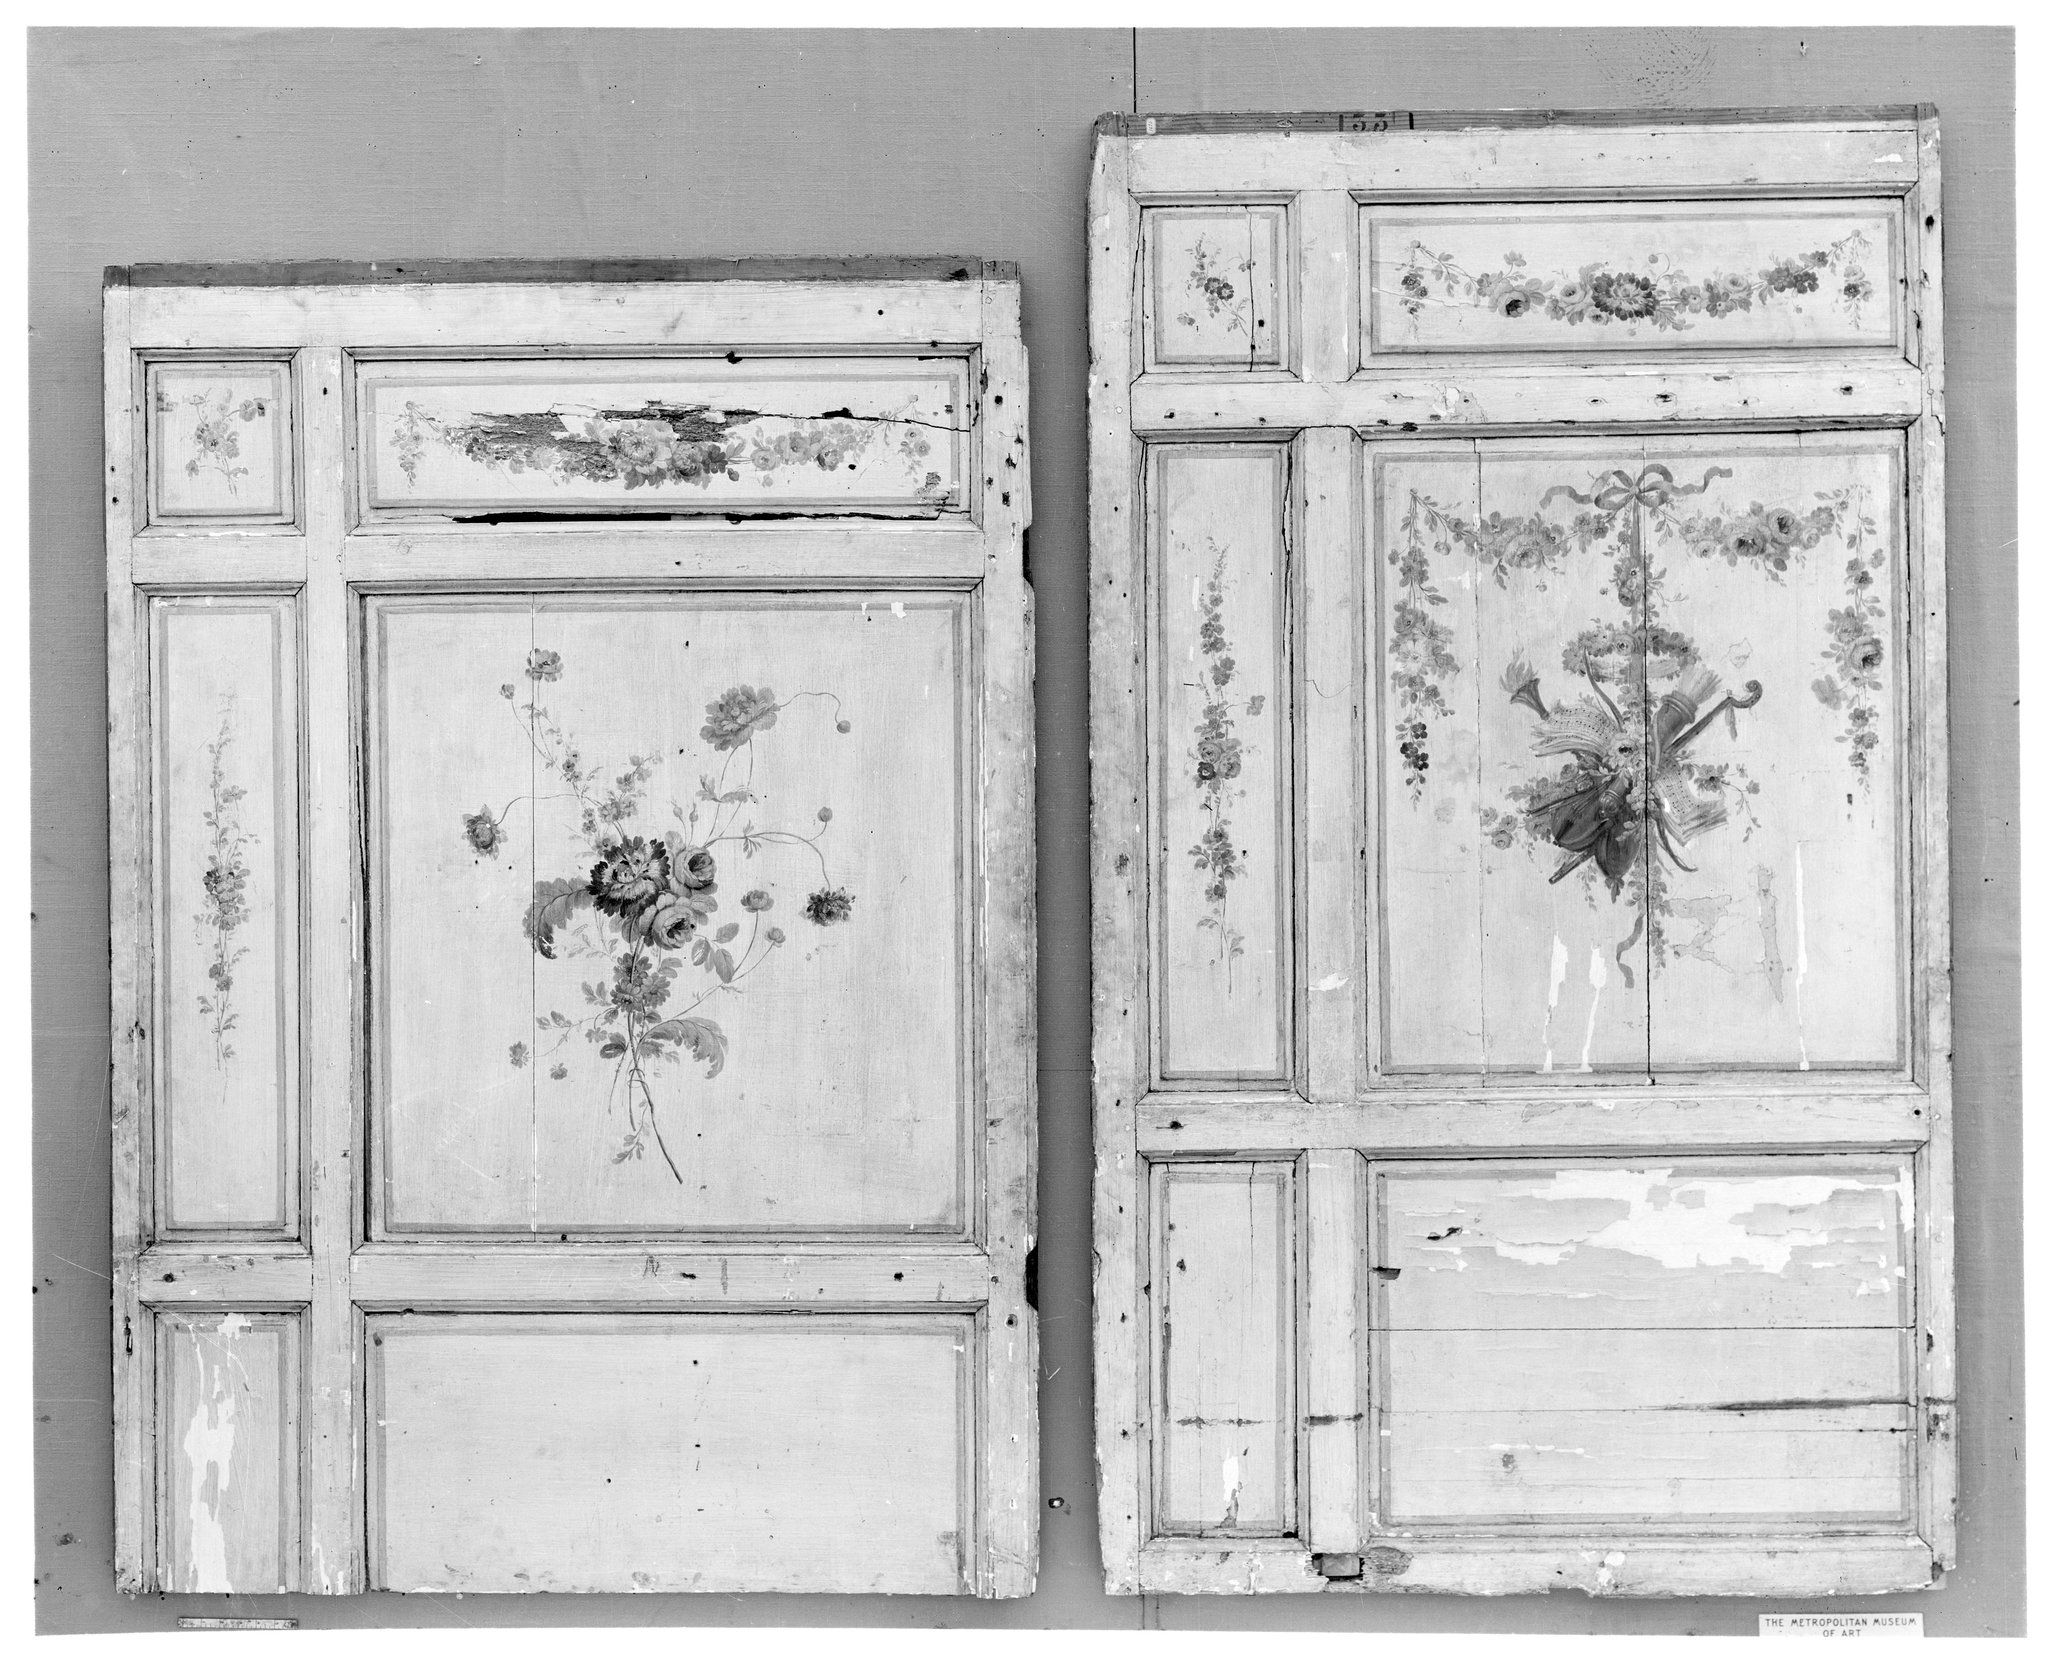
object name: wall paneling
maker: pierre ranson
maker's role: maker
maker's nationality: french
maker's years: 1736-1786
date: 1770-1780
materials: wood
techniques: painting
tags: flowers,leaves